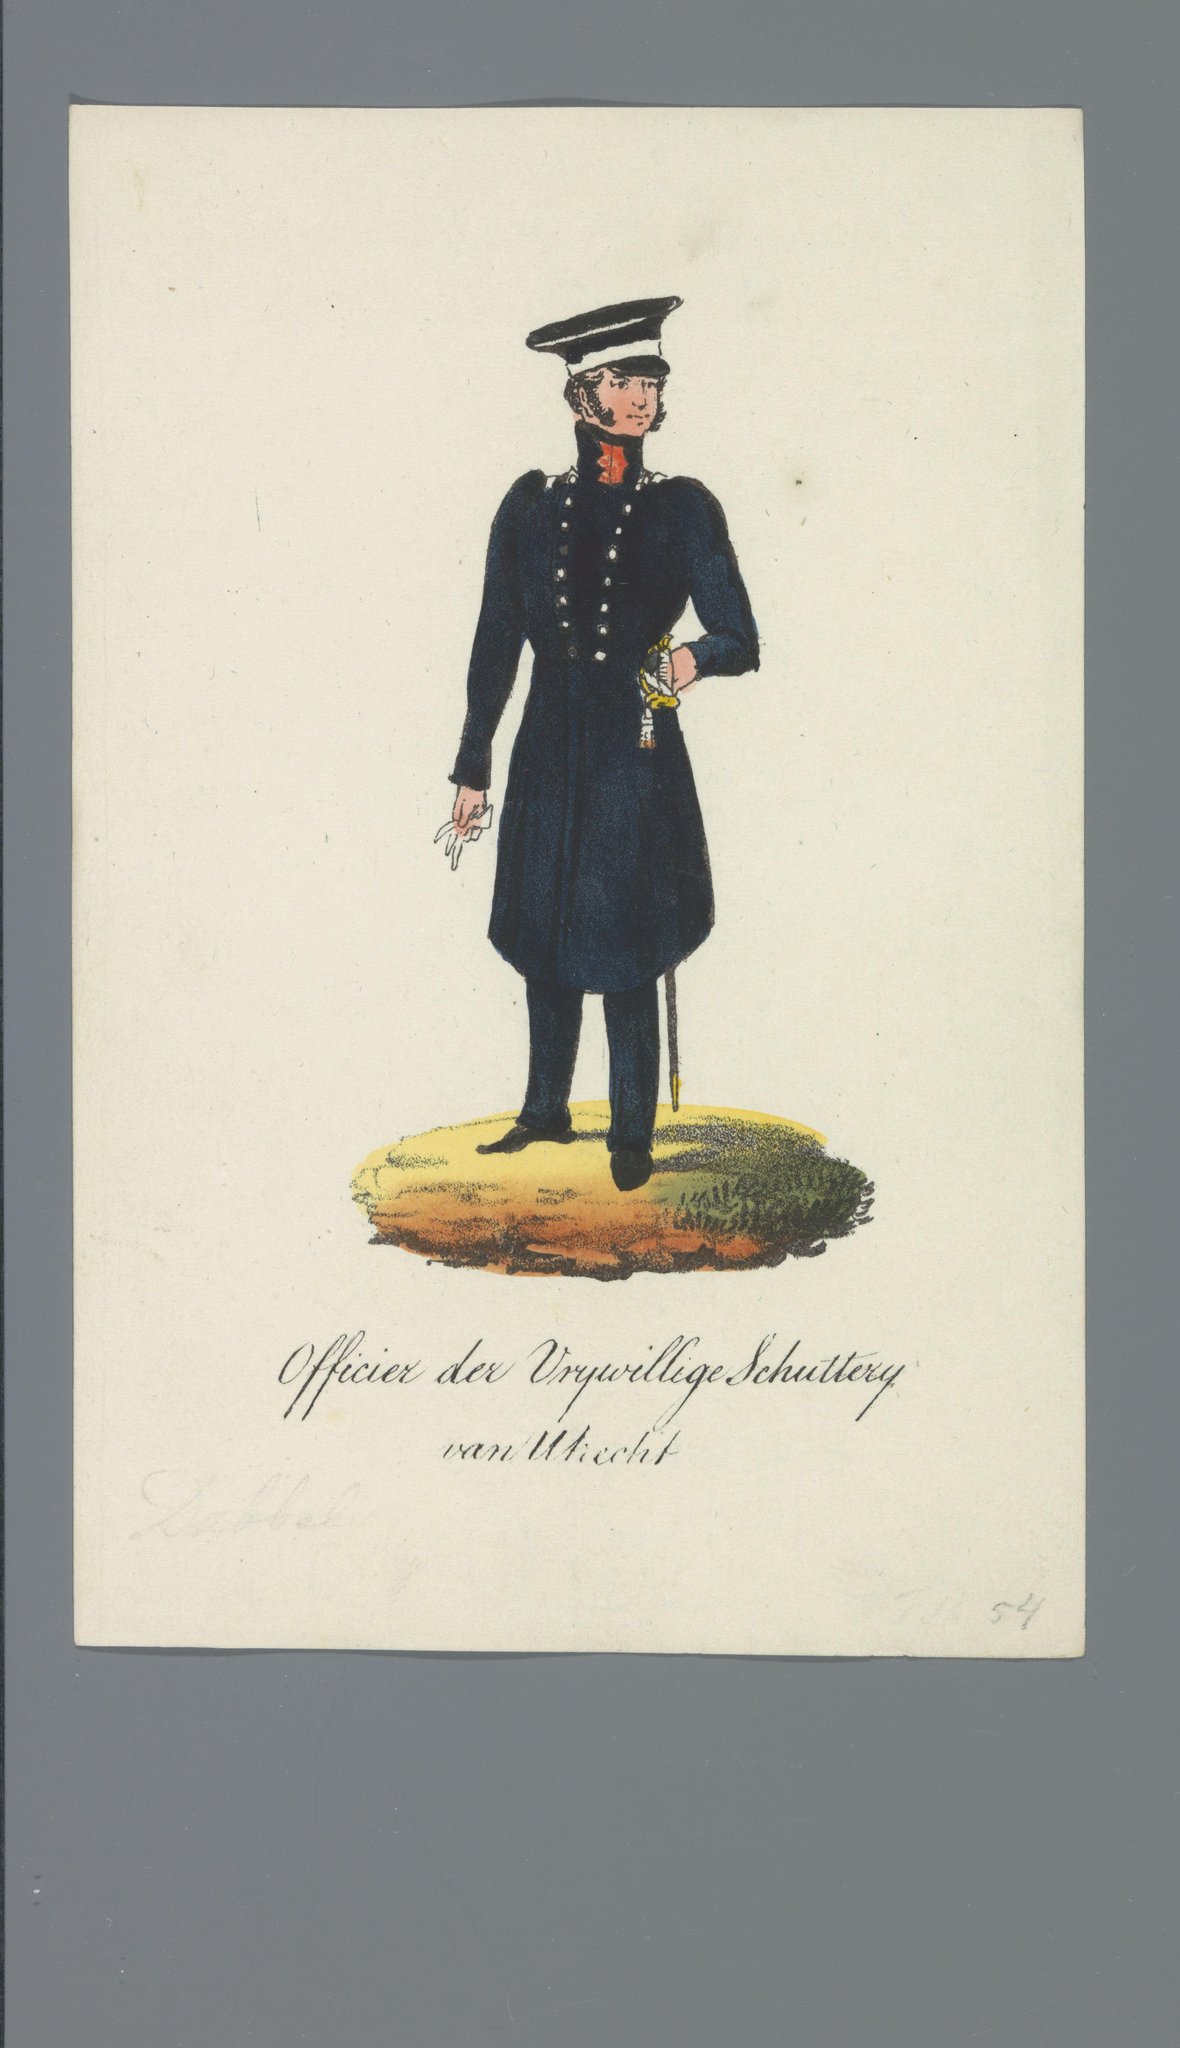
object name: costume print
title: Nederlandse militaire uniformen in de jaren 1830-1832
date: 1835-1850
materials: paper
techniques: hand coloring, lithograph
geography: utrecht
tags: (military) uniforms, clothes, costume, utrecht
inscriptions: collector's mark: Lugt 2228, collector's mark: Lugt 2227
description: Staande officier van de Afdeling Utrechtse Schutterij. Onderdeel van een serie van 157 losse bladen met Nederlandse militaire uniformen in de jaren 1830-1832.